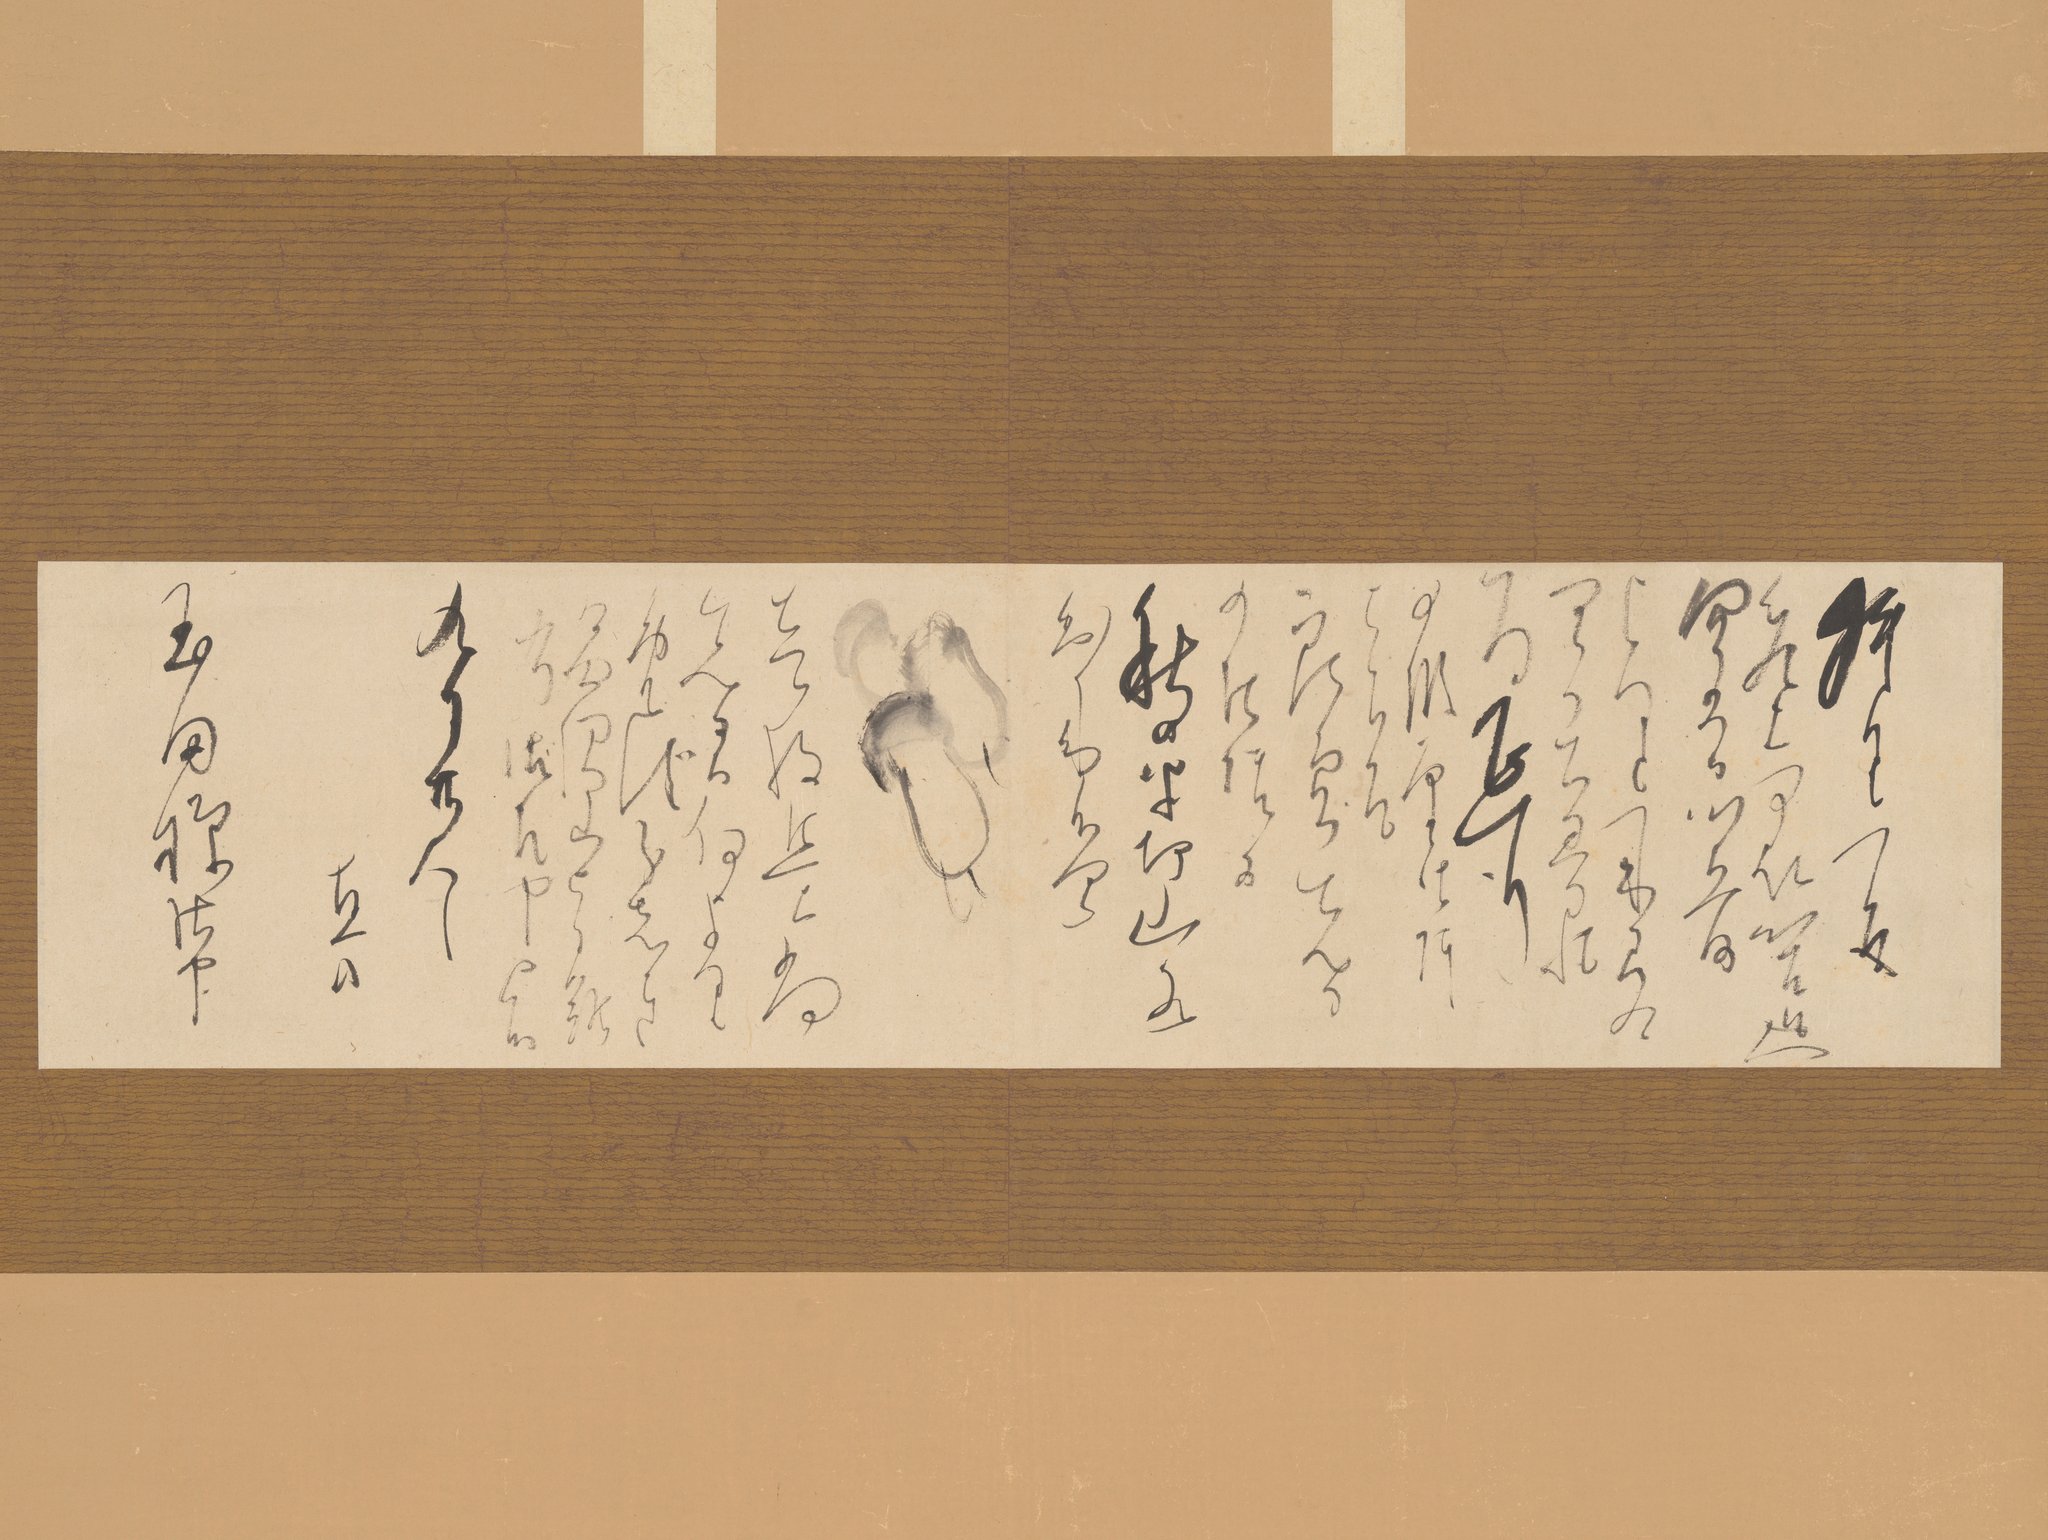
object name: hanging scroll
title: Letter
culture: japanese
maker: tanomura chokunyū 田能村直入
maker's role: artist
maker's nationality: japanese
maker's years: 1814-1907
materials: ink, paper